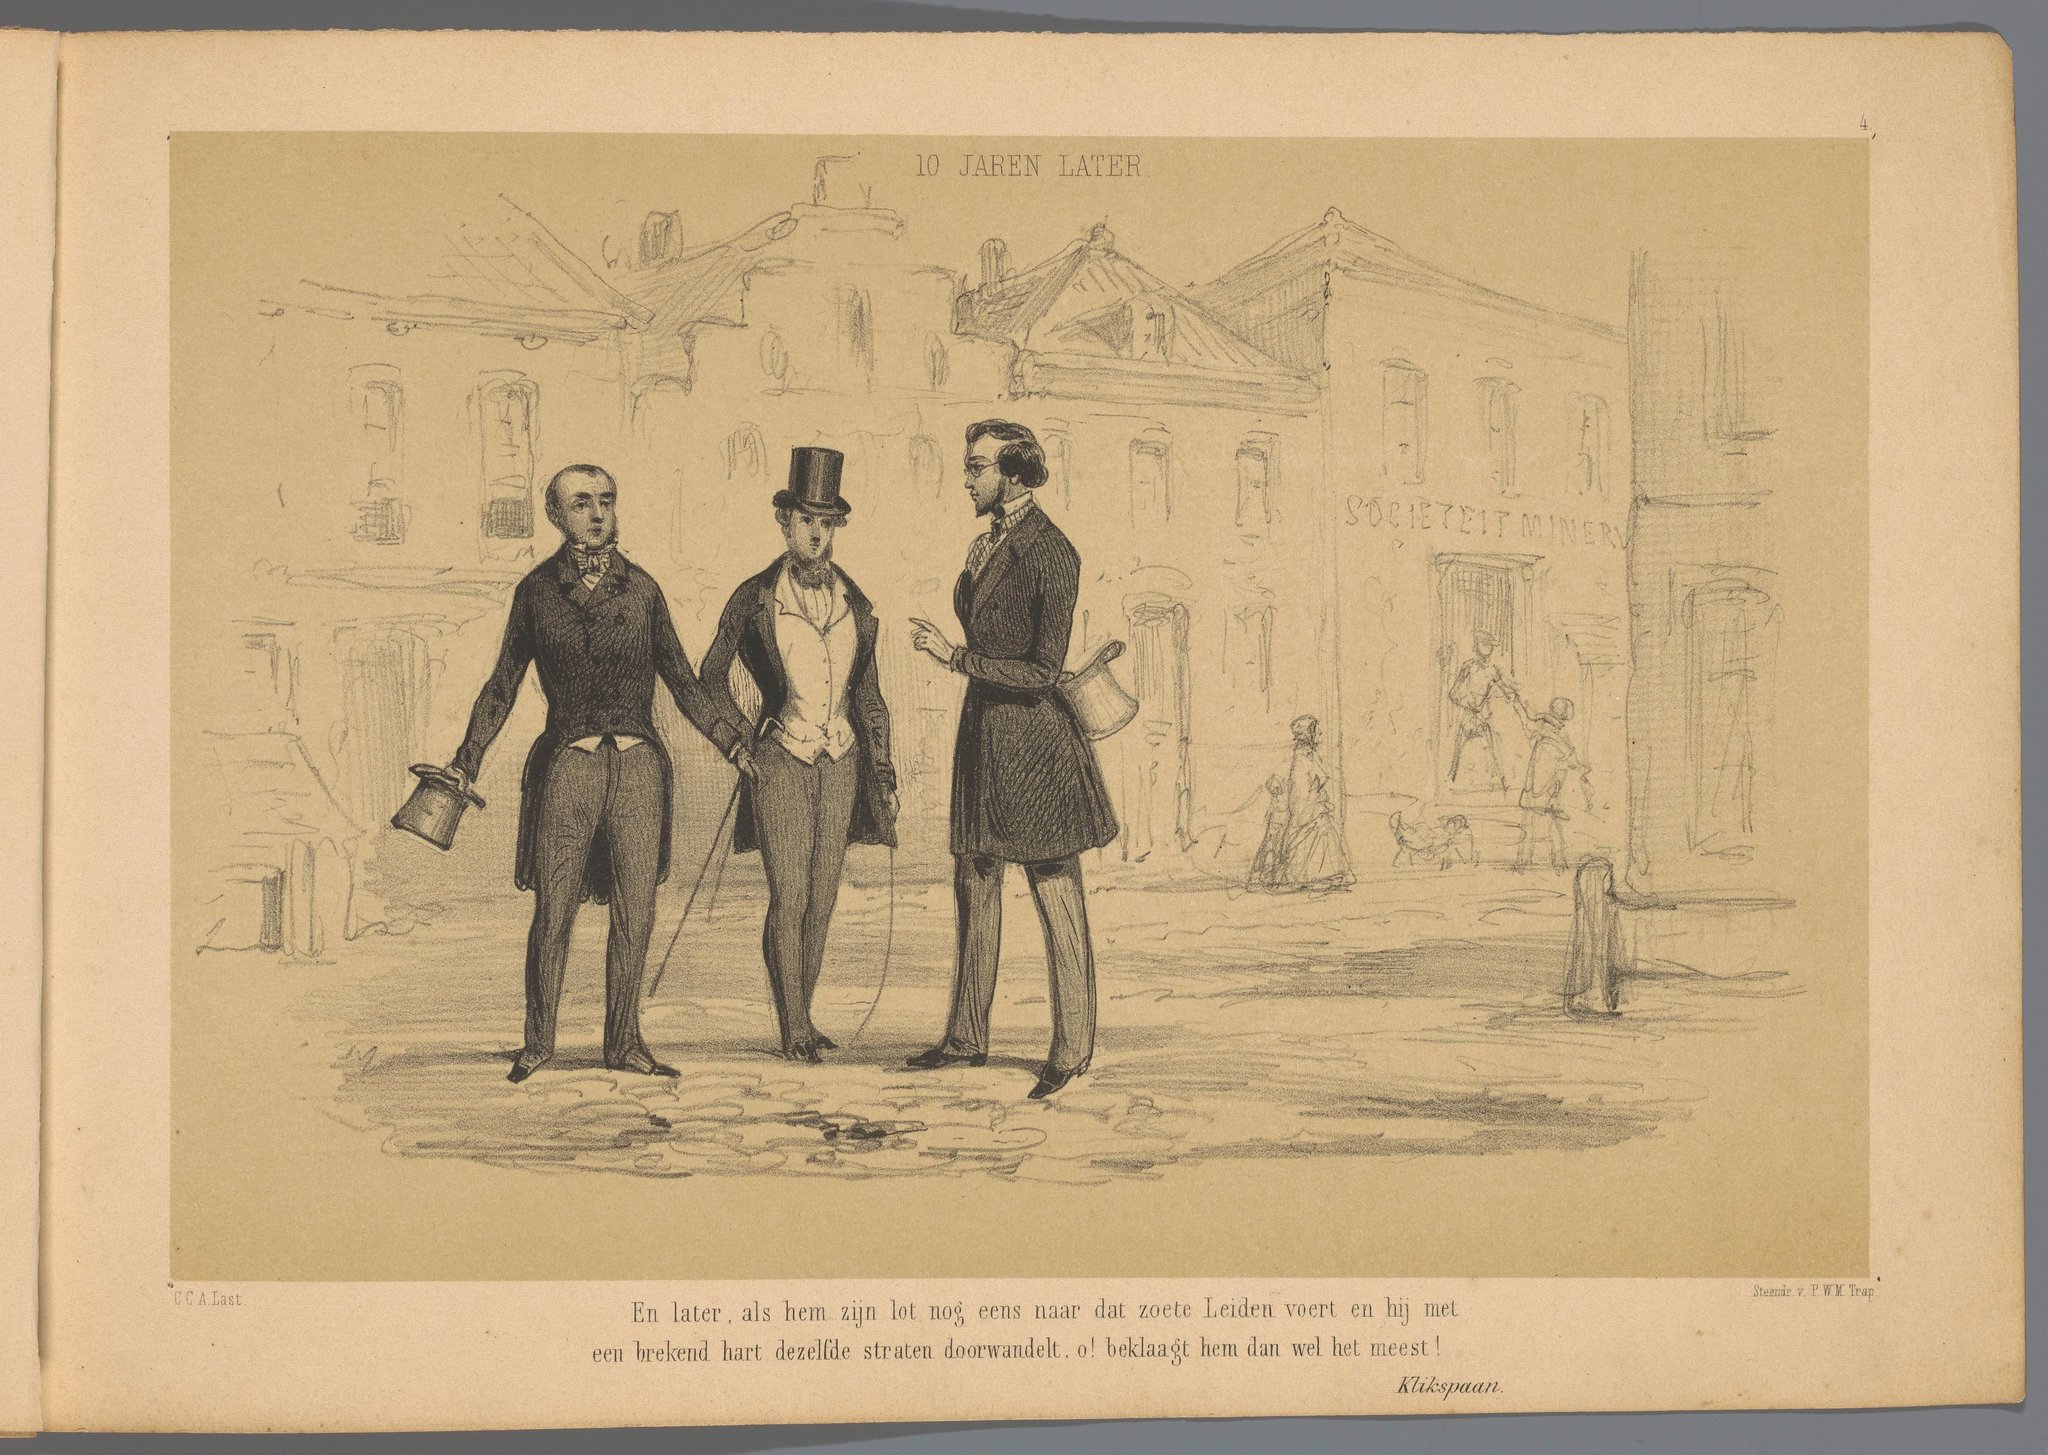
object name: print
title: Tien jaren later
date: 1844-1876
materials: paper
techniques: tone lithography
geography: the hague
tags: club (students), meeting, student life, leiden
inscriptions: collector's mark: Lugt 2228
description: De serie met omslag werd samengesteld door Jan van der Hoeven (Leiden 1834 - Rotterdam 1900). Van der Hoeven was mede oprichter van het Sophia-Kinderziekenhuis in Rotterdam en was als heelmeester verbonden aan het stedelijk ziekenhuis aldaar.